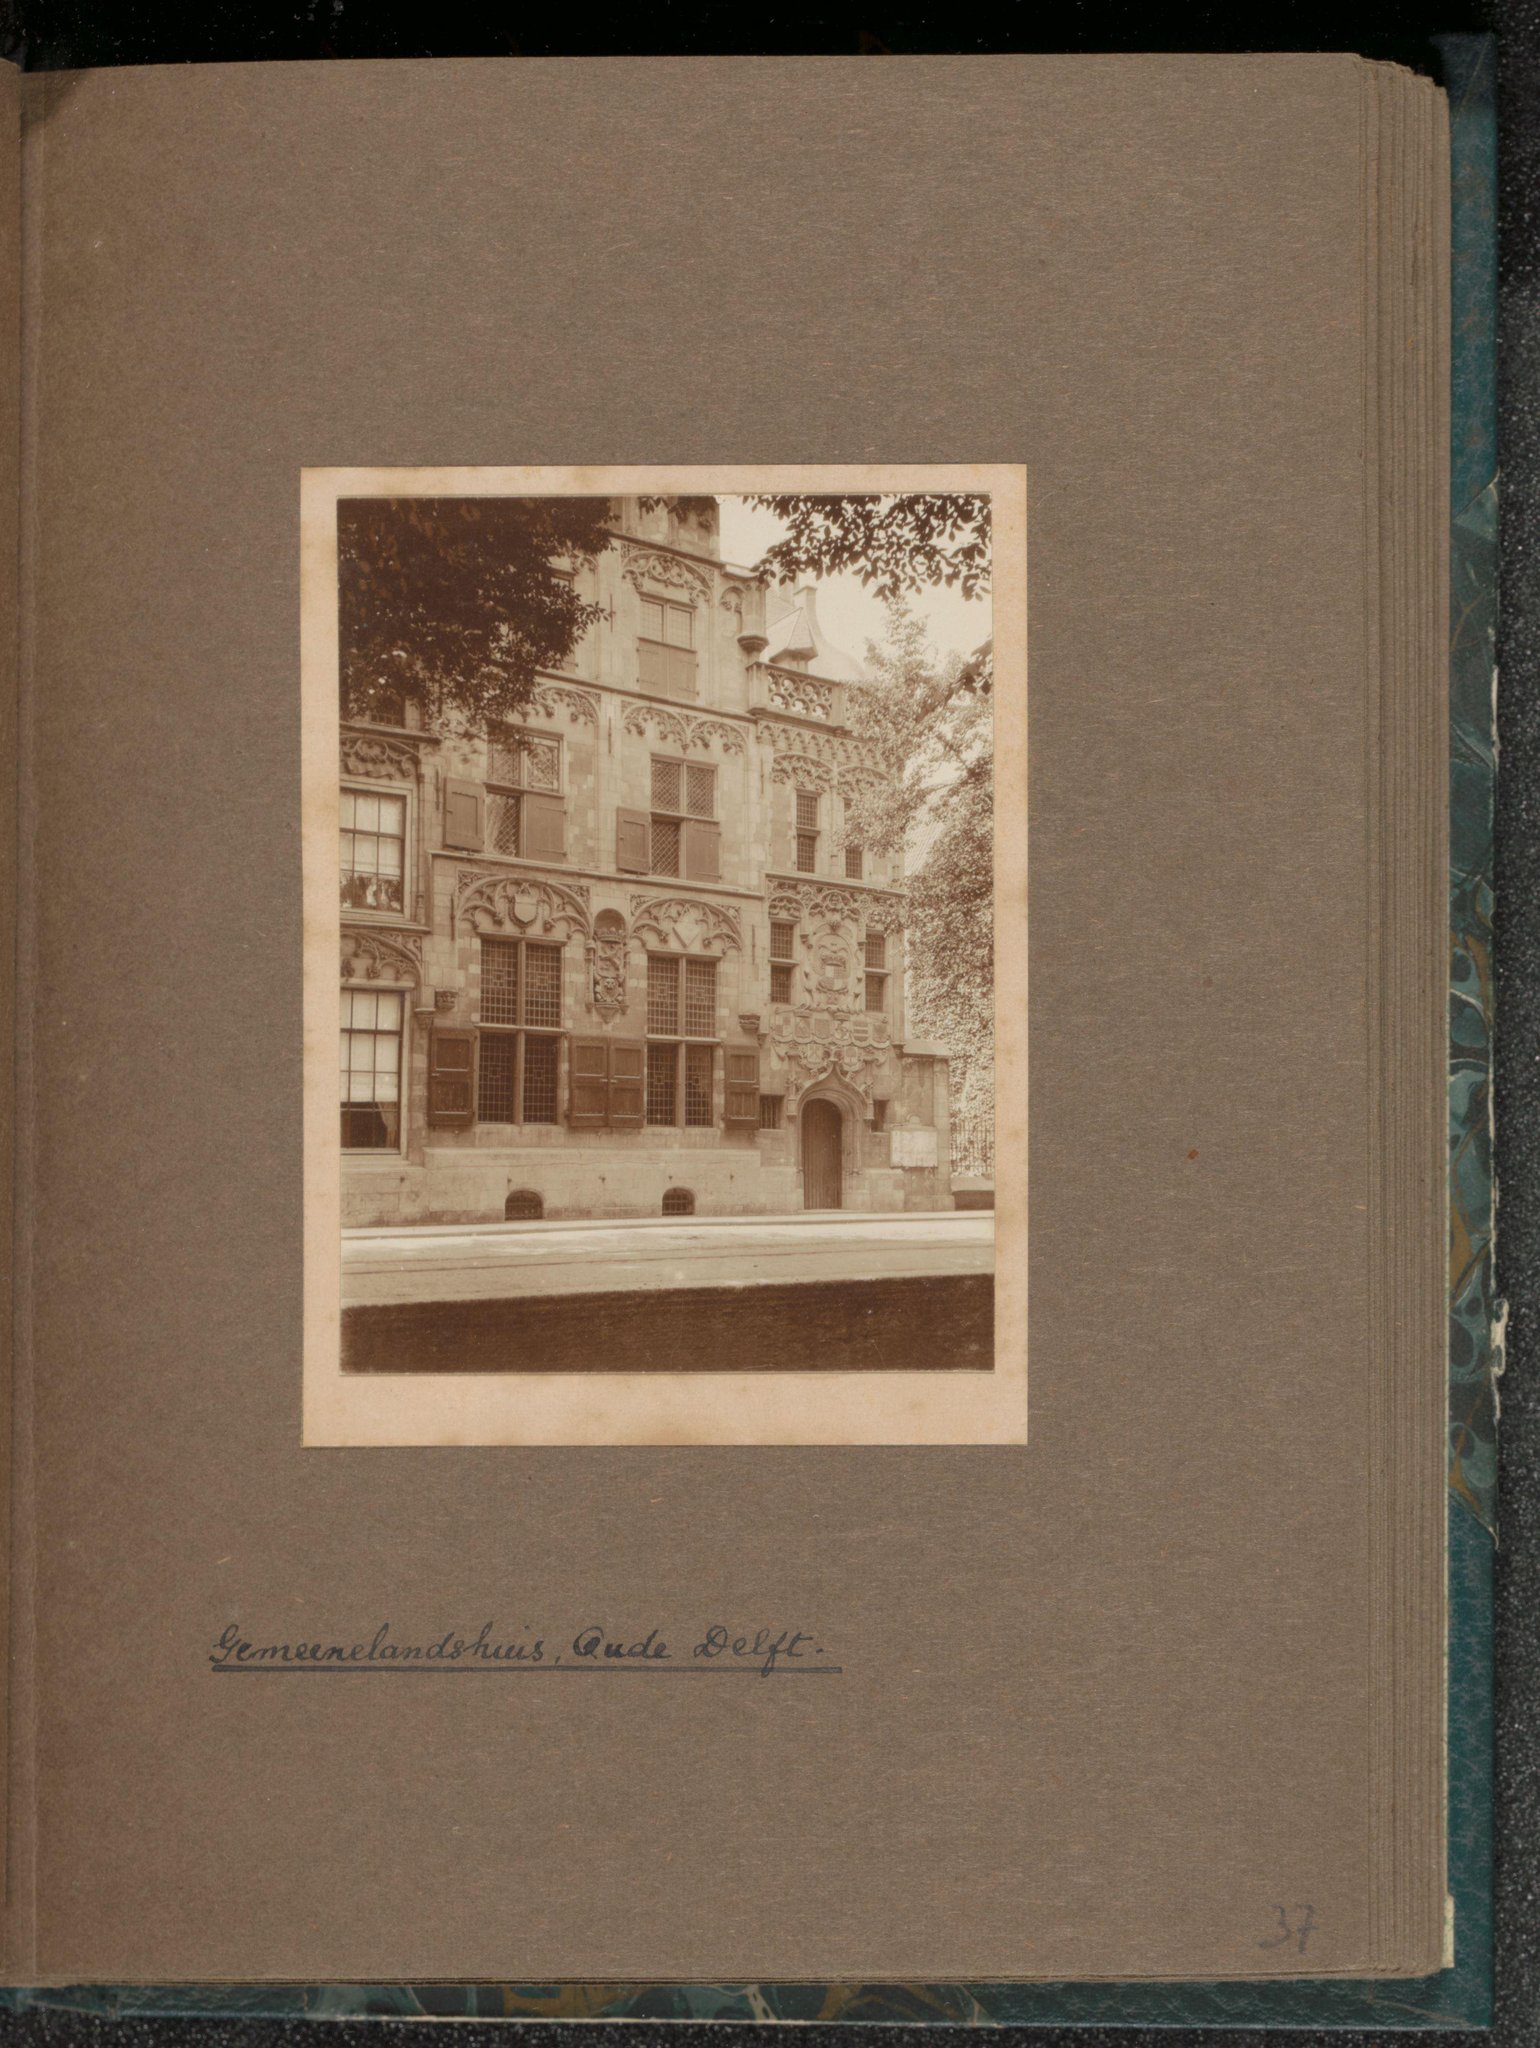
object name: photograph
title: Voorgevel van het Gemeenlandshuis te Delft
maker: Anonymous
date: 1912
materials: photographic support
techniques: gelatin silver print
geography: delft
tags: coat of arms (as symbol of the state, etc.), ornament ~ cartouche, travelling; tourism, façade (of house or building), delft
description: Onderdeel van Fotoalbum van de excursie naar Nederland van de Britse amateurfotografenvereniging P.C.U.K.